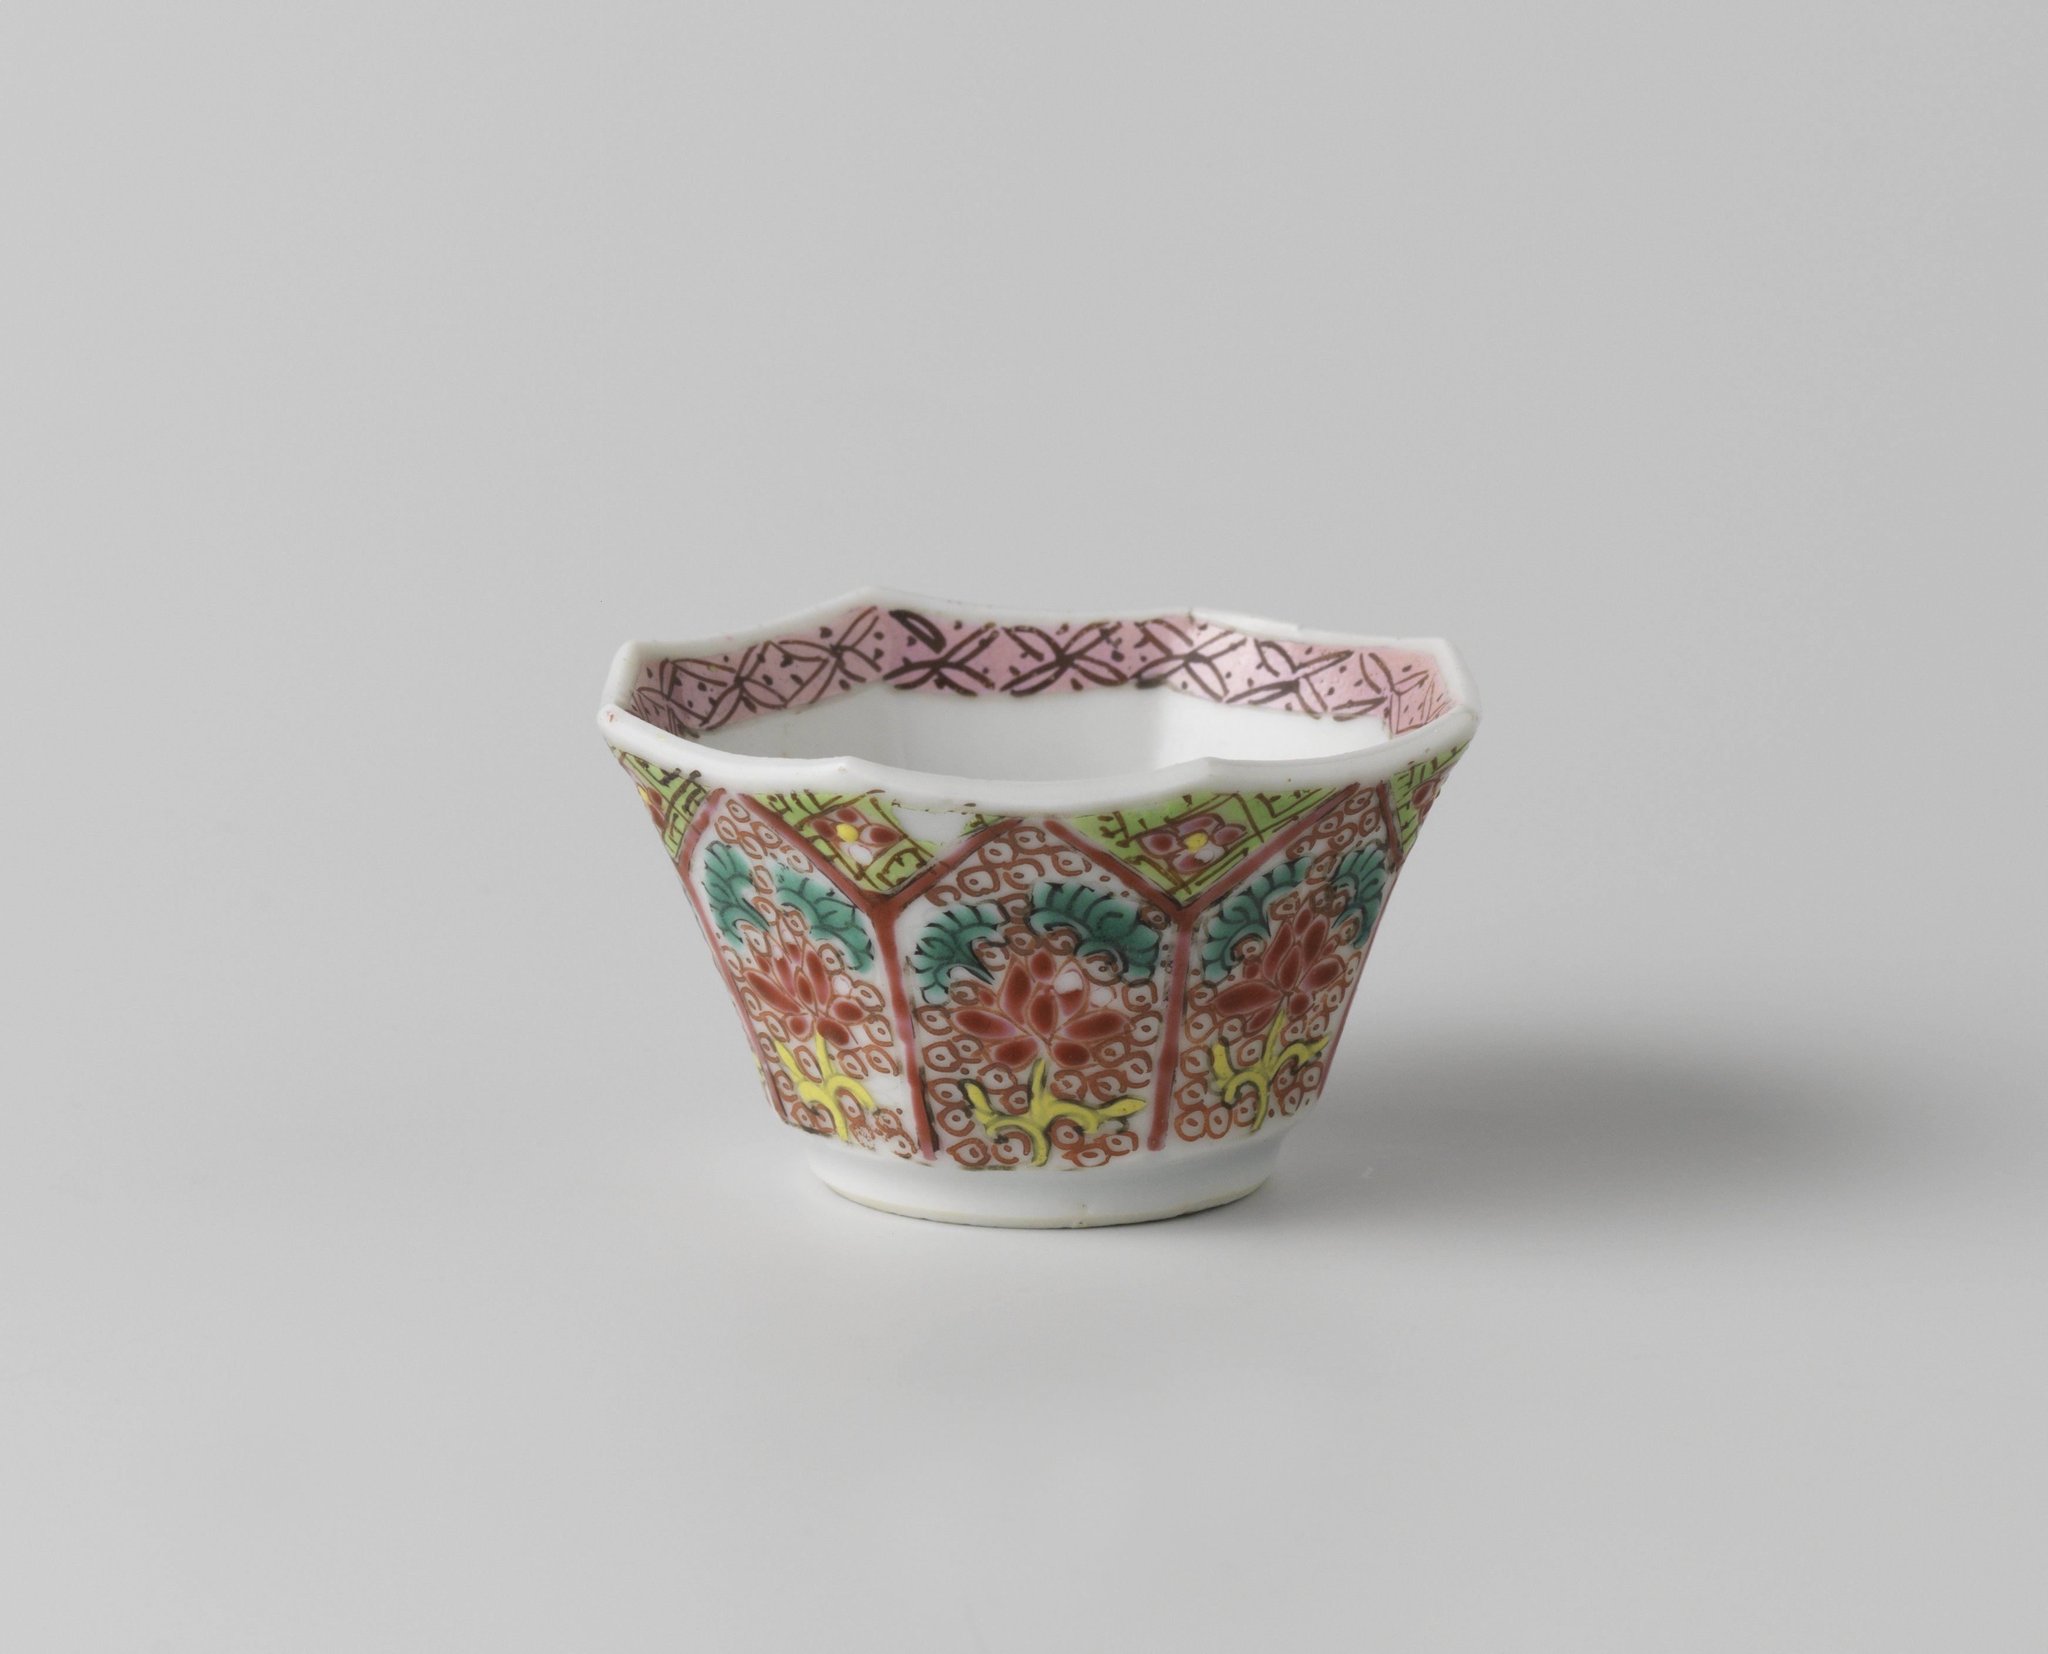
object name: kop en schotel, kop en schotel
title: Octagonal cup with foral scrolls in petal-shaped panels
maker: Anonymous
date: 1725-1749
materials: glaze, paint, porcelain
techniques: firing, forming, turning, vitrification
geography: china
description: Kop en schotel, achtkantig van veelkleurig chinees porselein met bloemen en vogels.